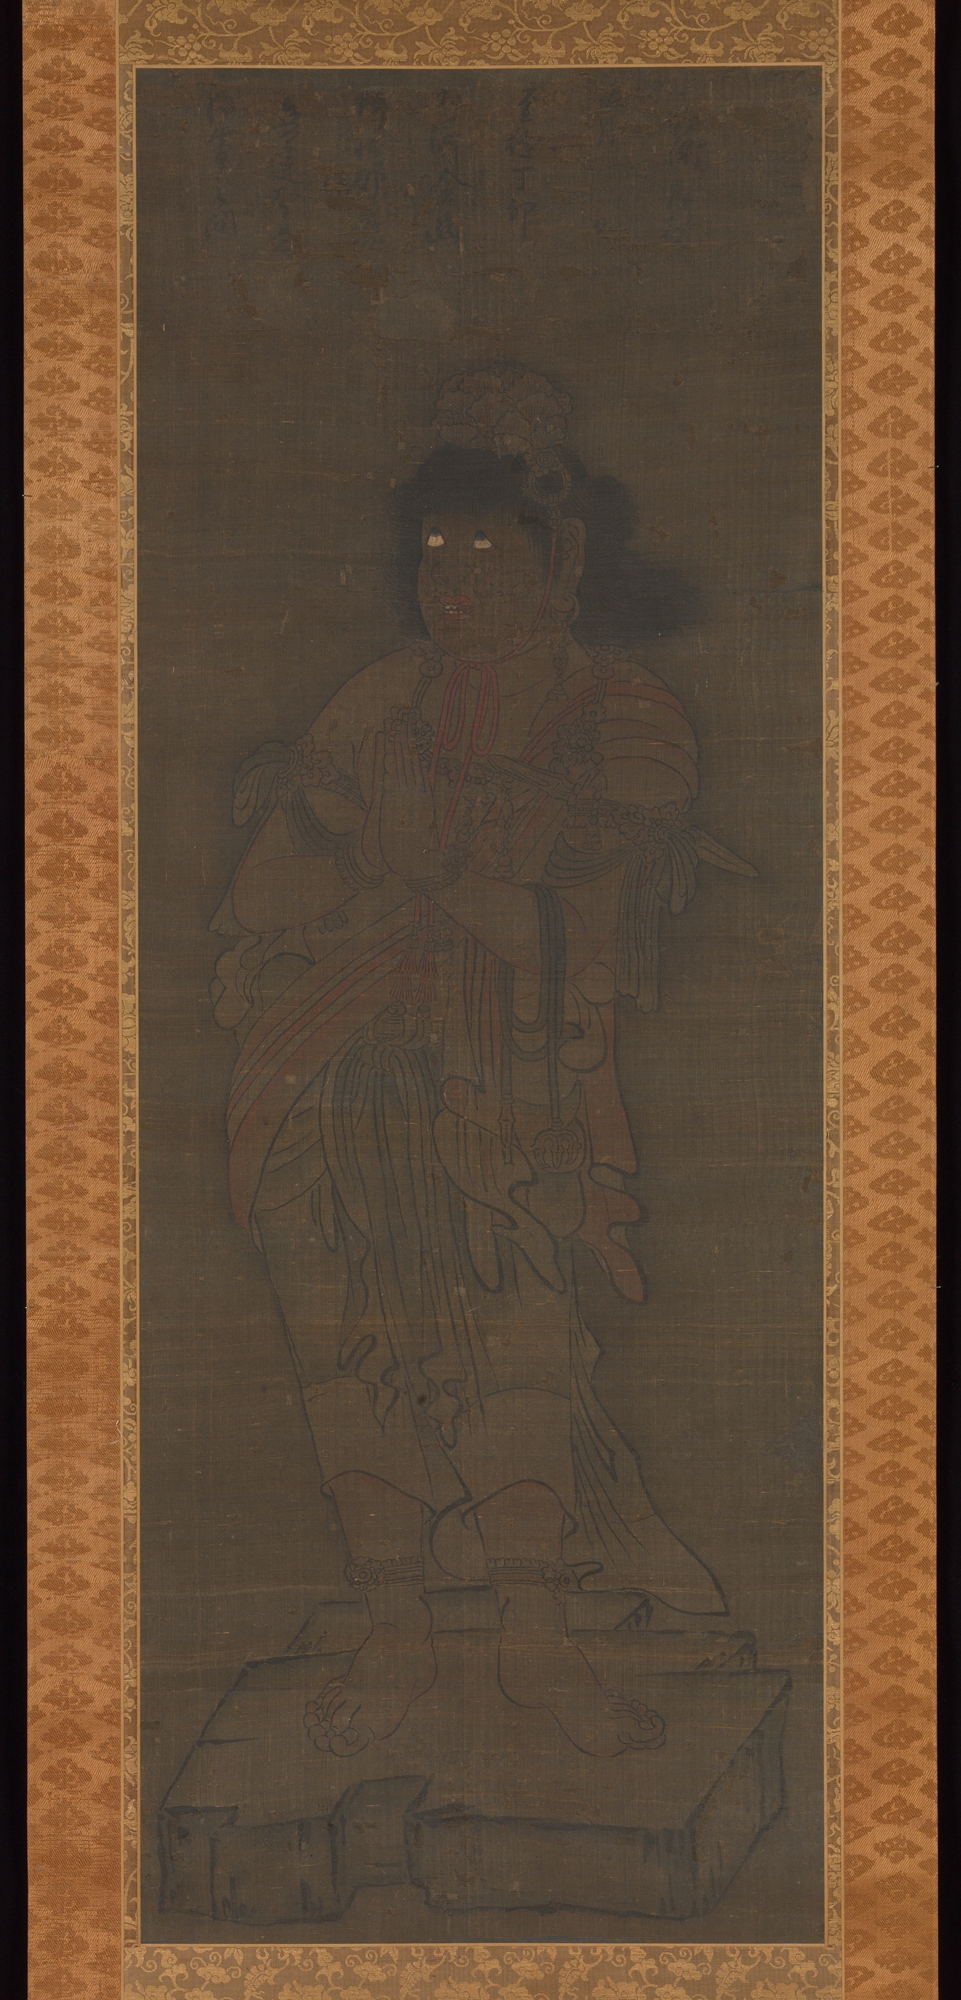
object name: hanging scroll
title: Kongara-doji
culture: japanese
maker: ryūshū shūtaku (myōtaku)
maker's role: artist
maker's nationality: japanese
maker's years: 1307-1388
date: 1387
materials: ink, silk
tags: men,monks